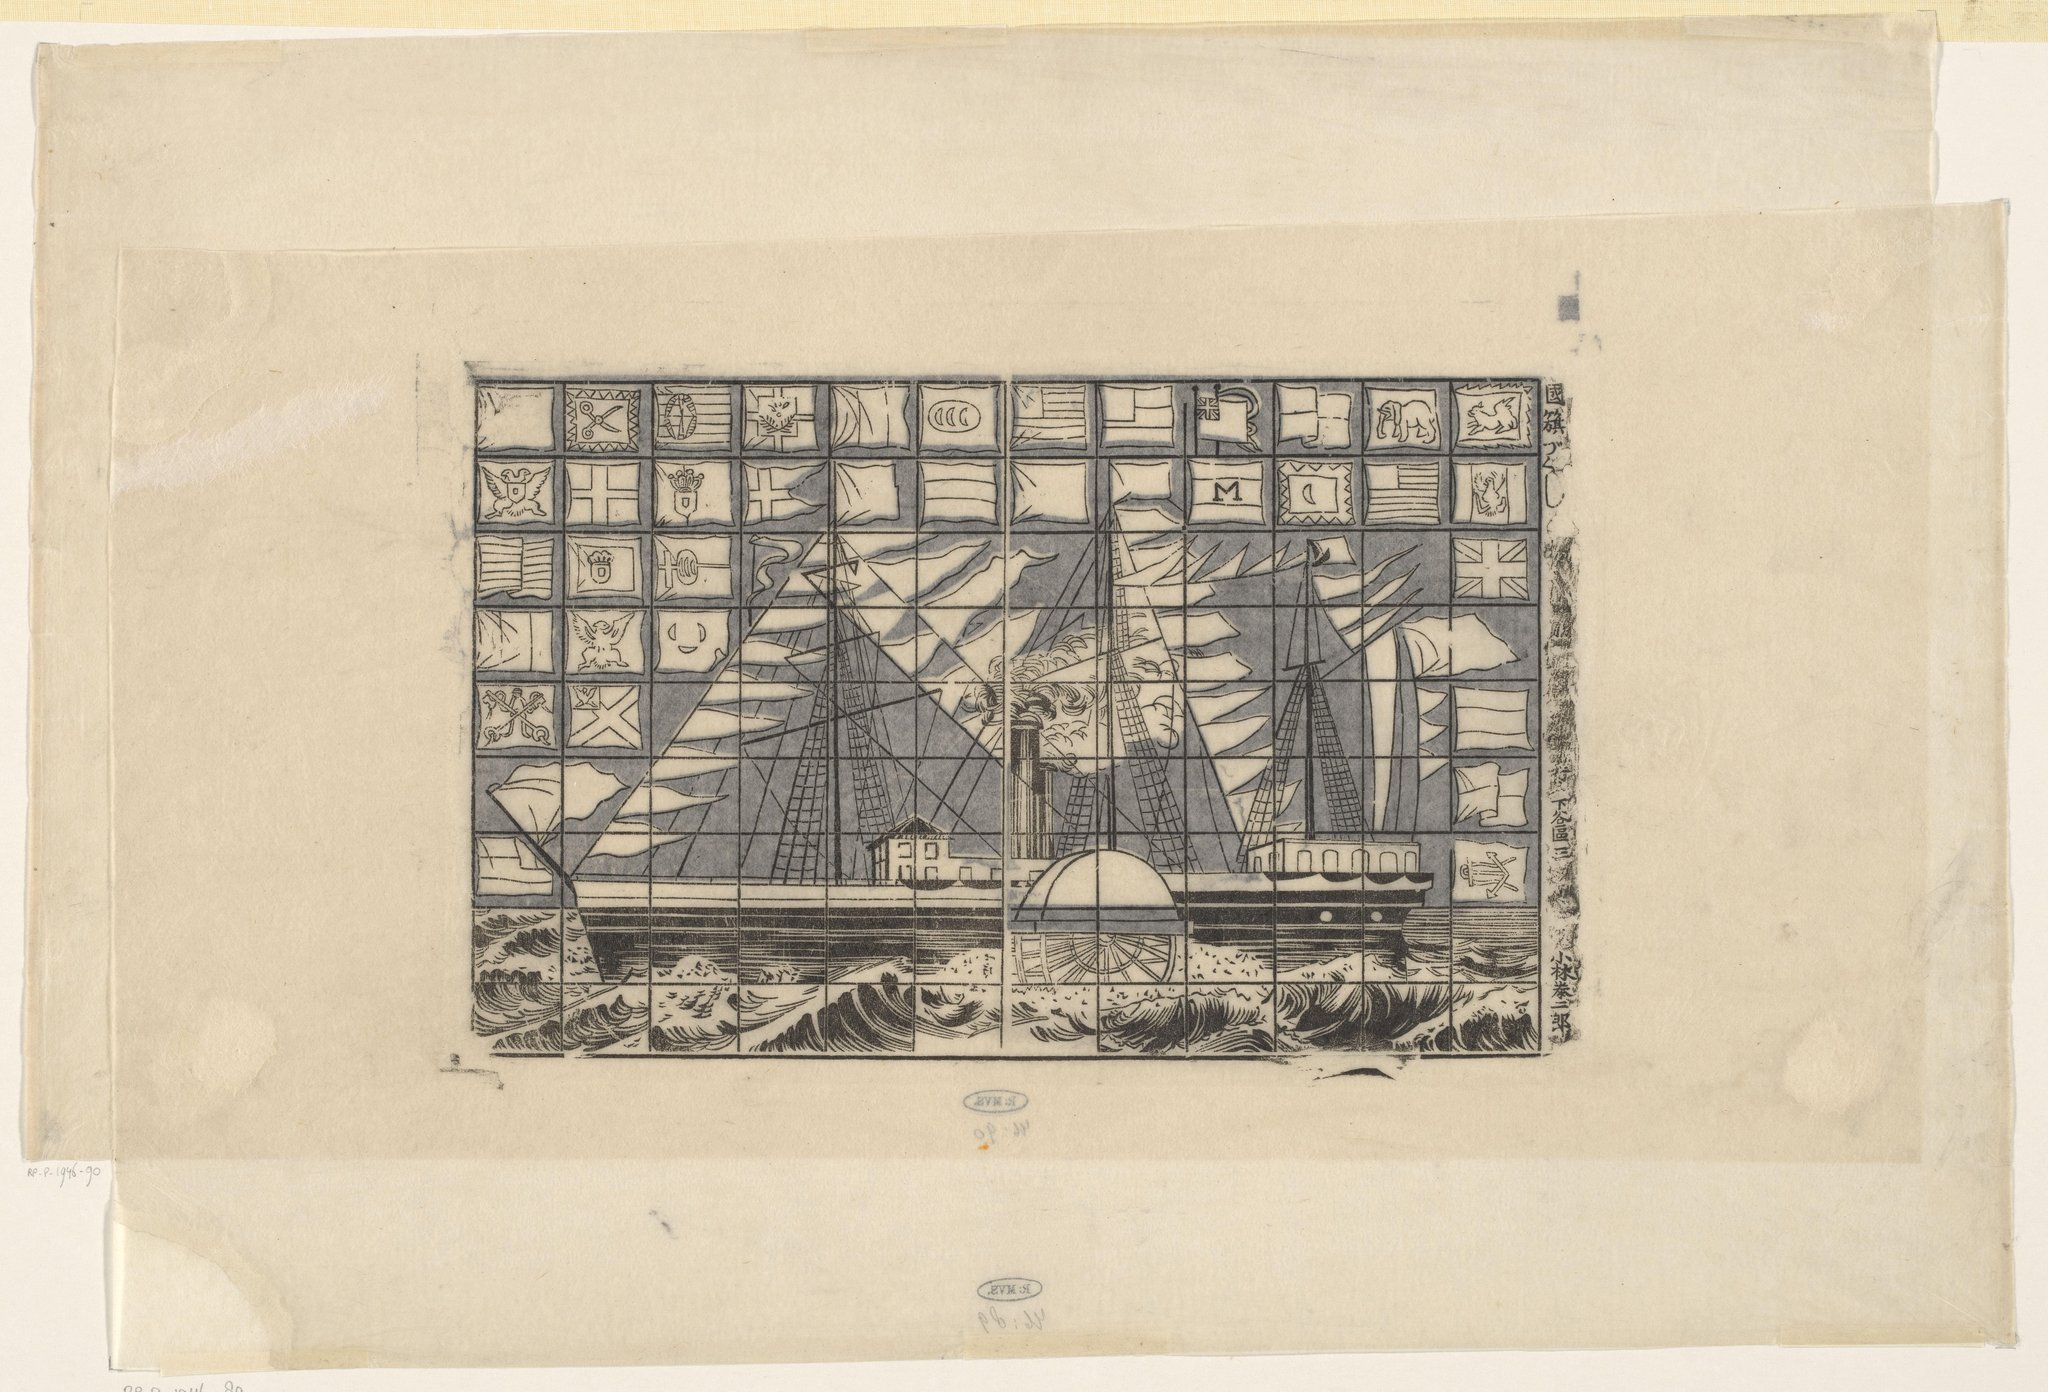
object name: print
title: Raderboot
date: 1883-1942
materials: paper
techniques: woodcut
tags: flag, colours (as symbol of the state, etc.), paddle-wheel boat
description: Raderboot met vlaggen achter een raster. Bovenaan zijn de vlakken van het raster gevuld met vlaggen van verschillende landen. Rechts Japanse karakters.